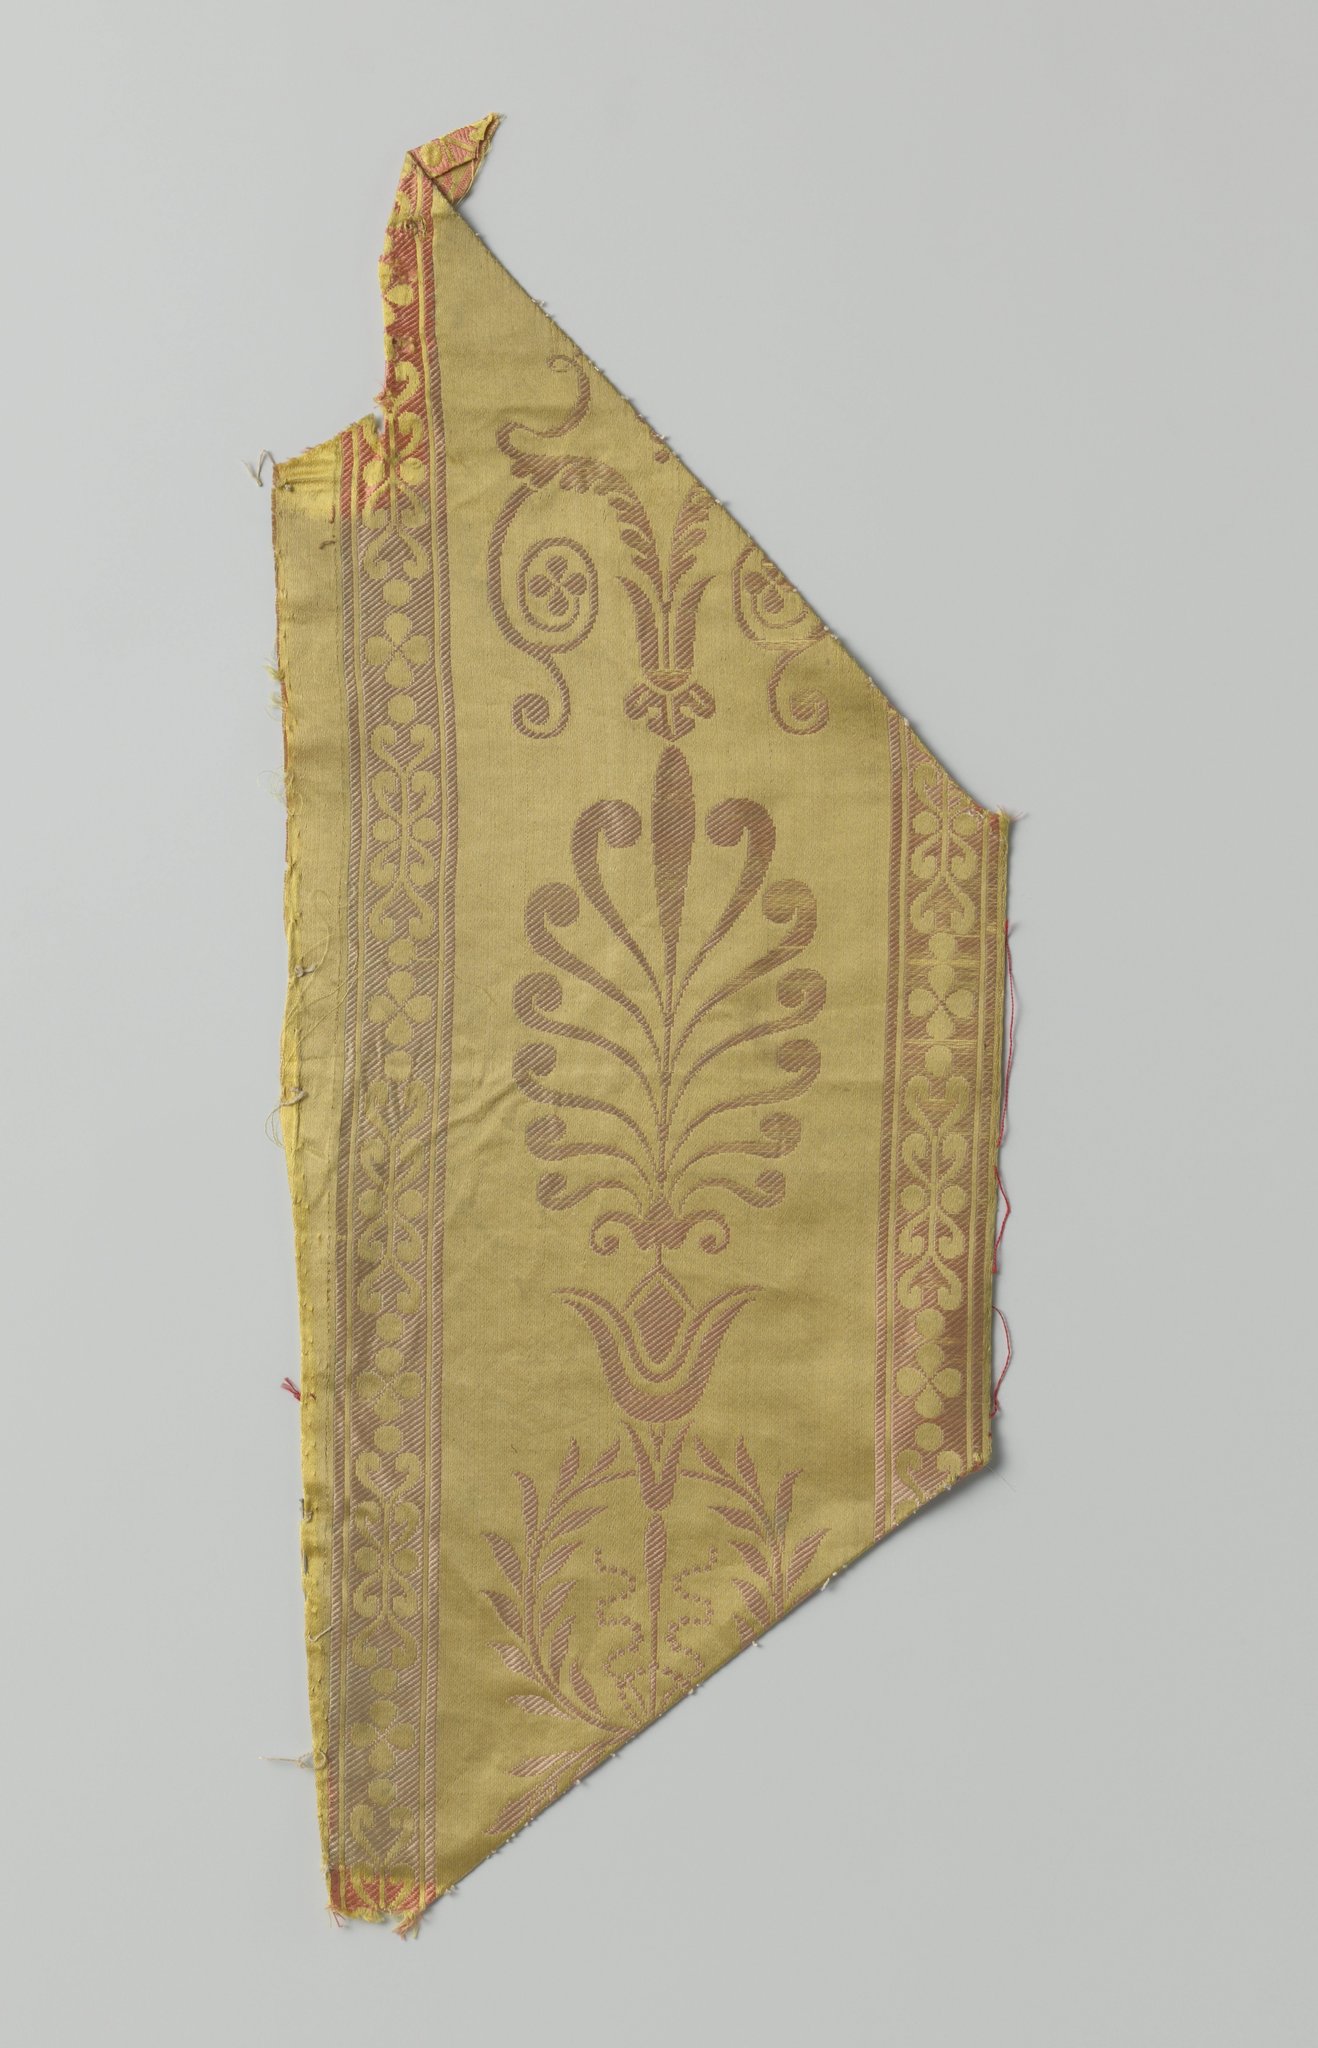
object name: stoelbekleding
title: Fragment zijdeweefsel van een stoelbekleding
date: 1805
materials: silk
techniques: brocade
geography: france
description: Fragment geel zijdeweefsel, van een stoelbekleding. Het patroon heeft op een gele grond roze palmetten en arabesken. Het fragment hoort bij dertien fragmenten met invnr. BK-1992-18-A t/m BK-1992-18-M.